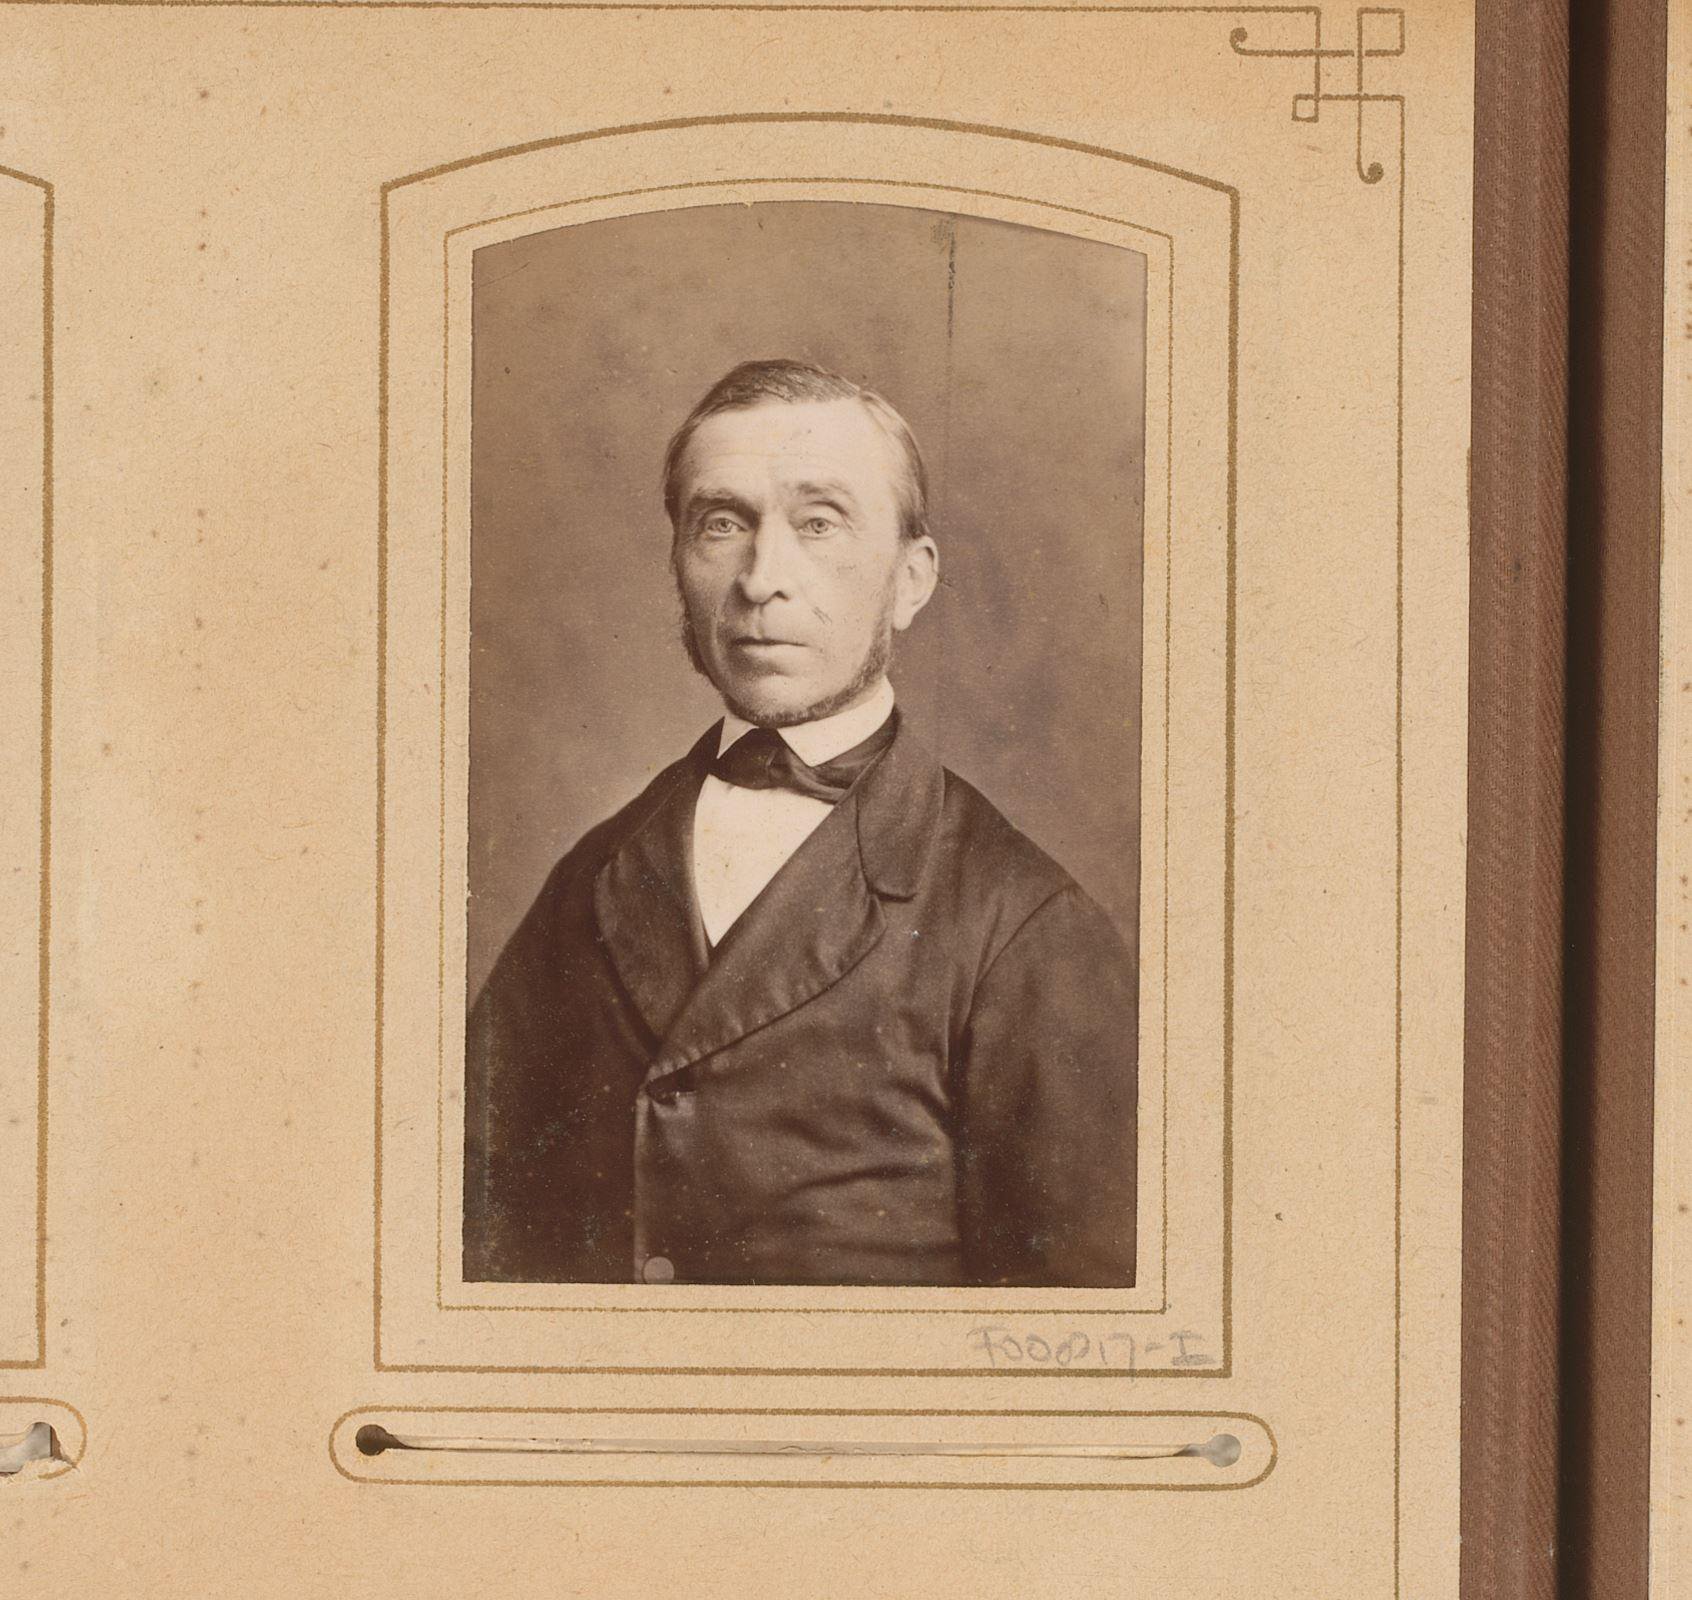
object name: photograph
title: Portret van een man met bakkebaarden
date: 1881-1904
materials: cardboard, photographic support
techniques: albumen print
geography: arnhem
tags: sideburns, historical persons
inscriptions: inscription: ‘Photographisch/ Atelier/ van/ Brainich & Leusink/ Menthensteeg No.7/ Arnhem’